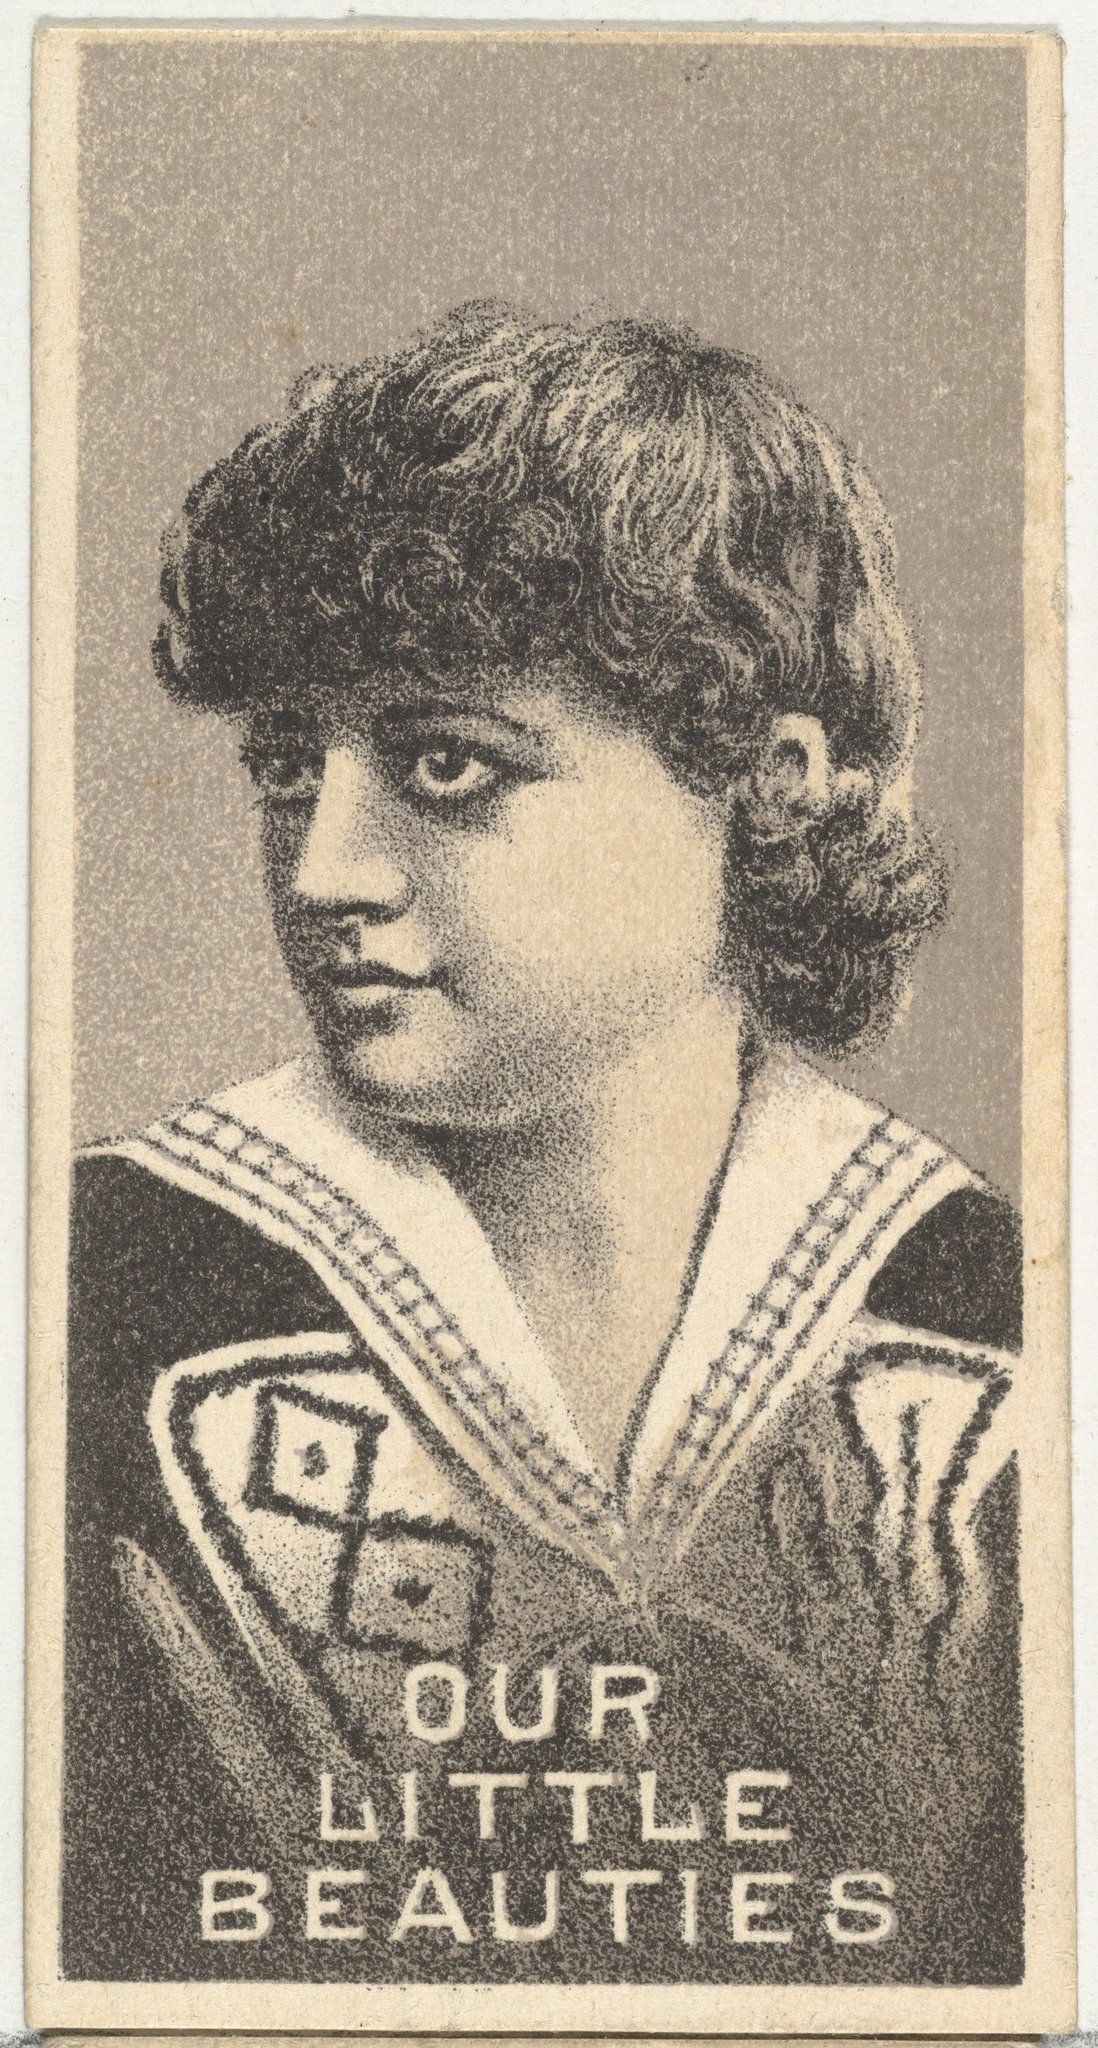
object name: print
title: From the Actresses series (N57) promoting Our Little Beauties Cigarettes for Allen & Ginter brand tobacco products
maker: allen & ginter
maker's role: publisher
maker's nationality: american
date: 1890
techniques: photolithograph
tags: portraits,women,actresses